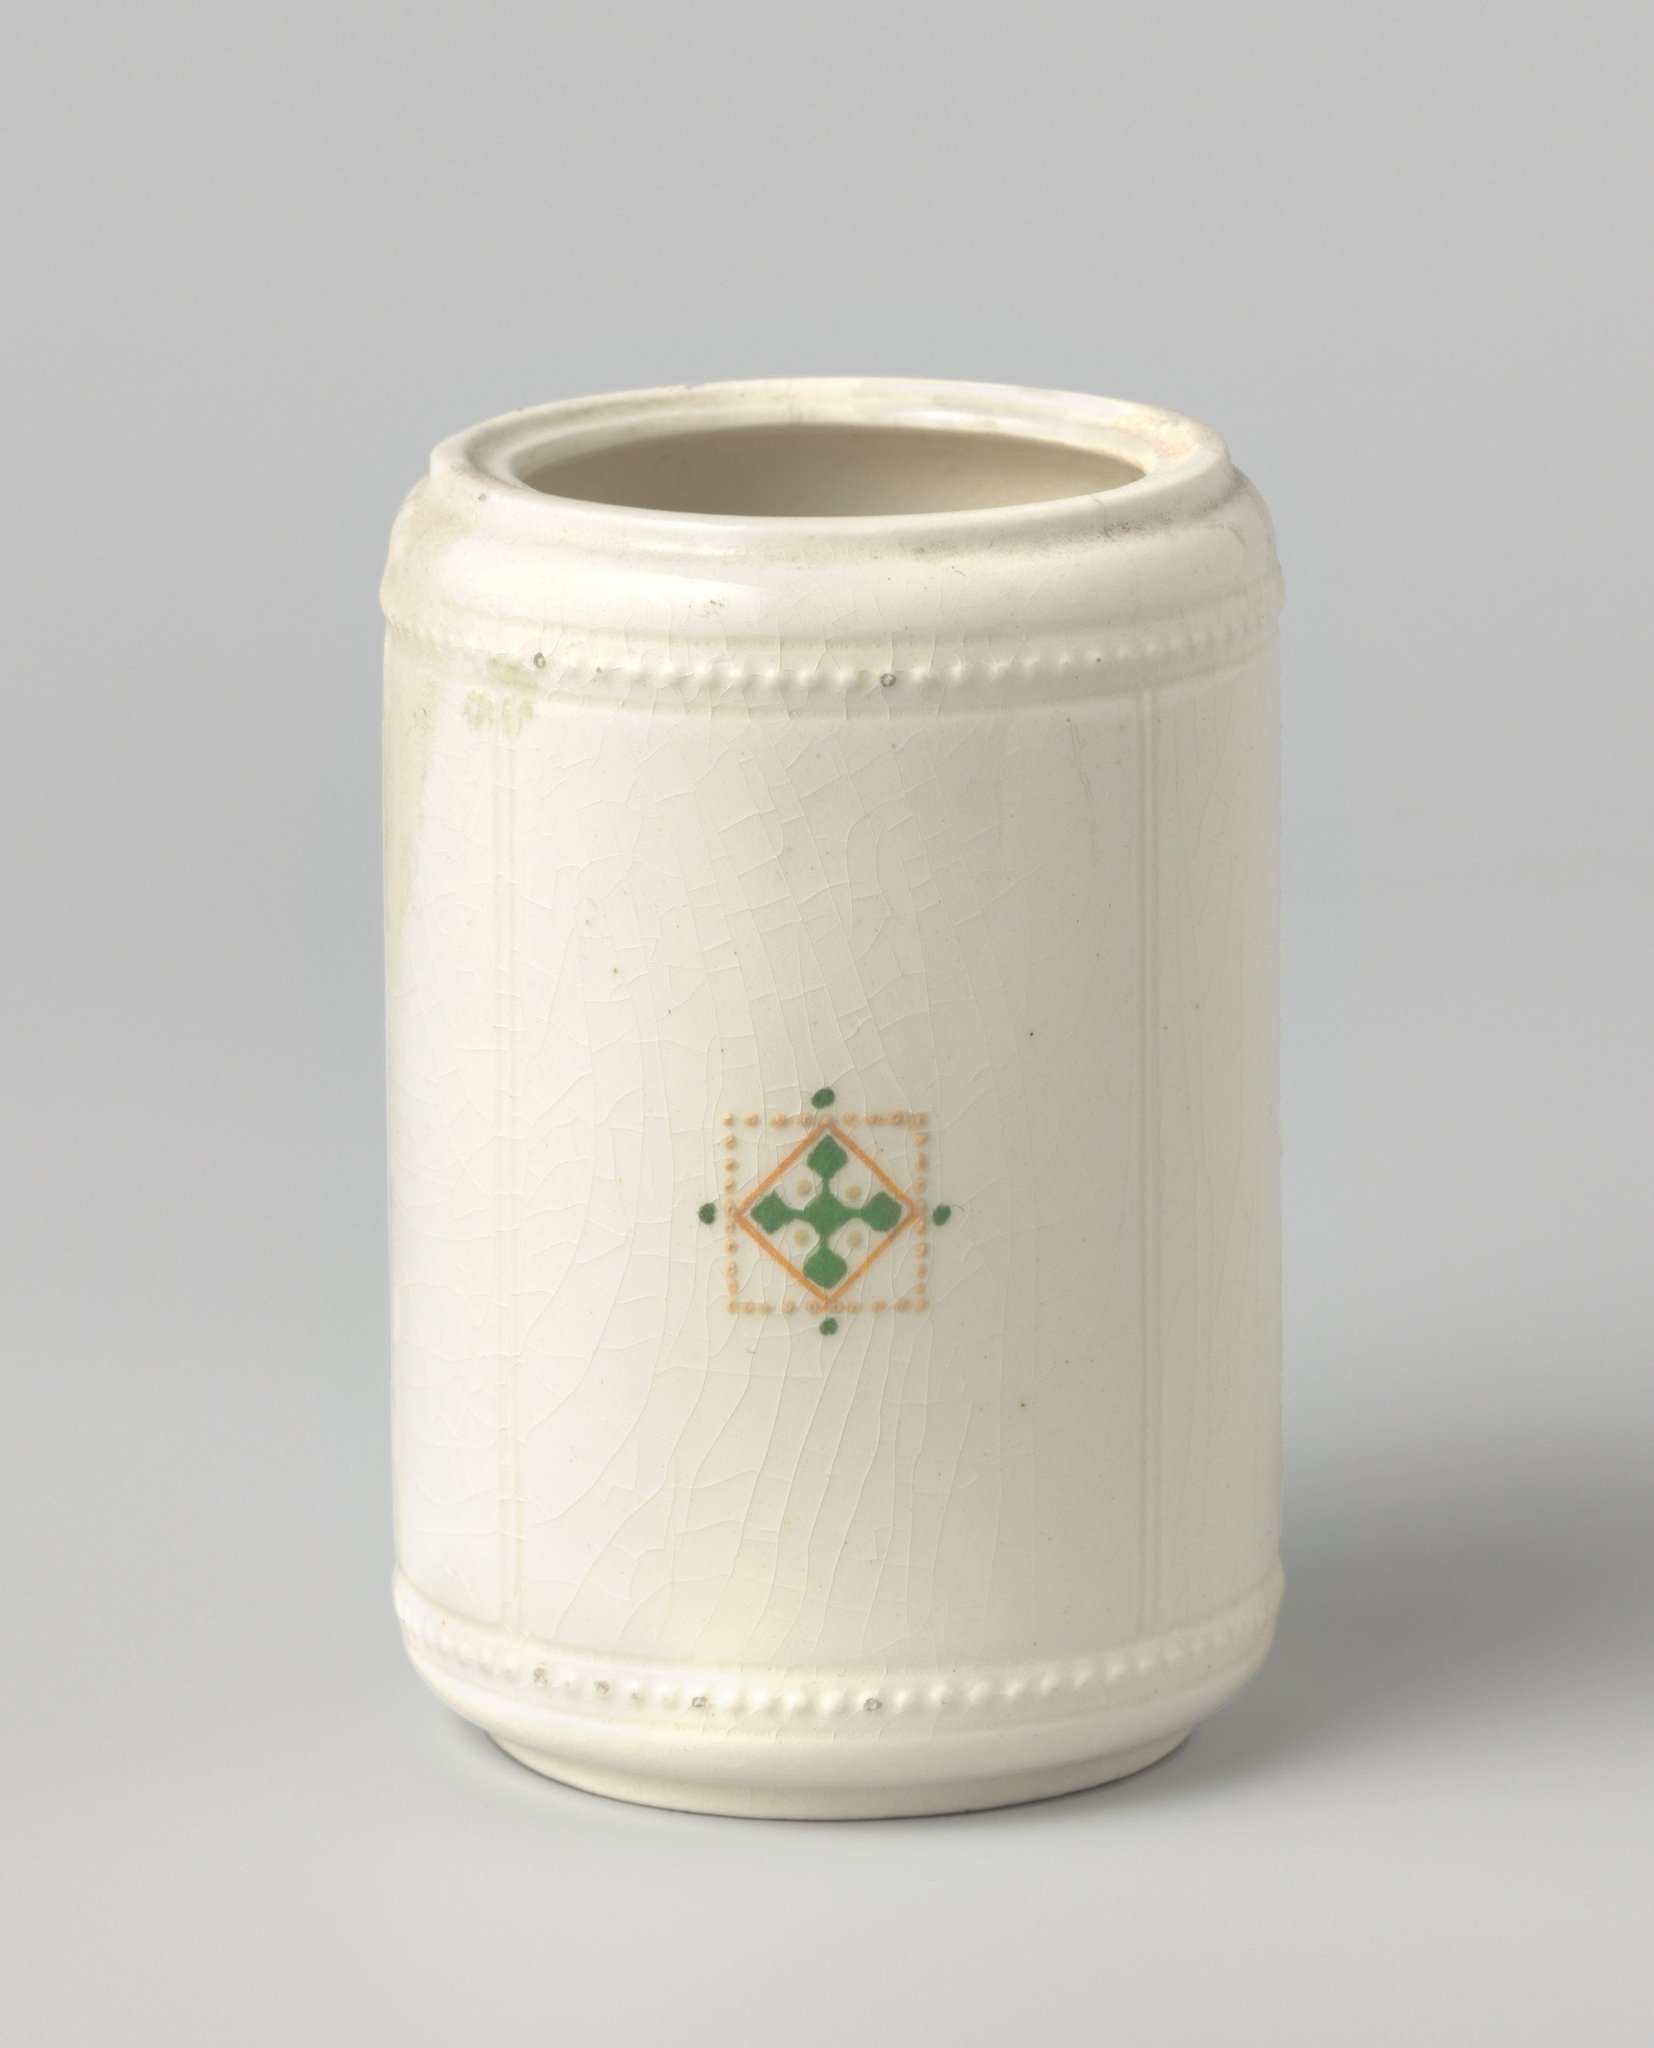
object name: pot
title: Pot met parellijst en geometrische motieven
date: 1904-1910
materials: earthenware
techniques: painted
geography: amsterdam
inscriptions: mark: ‘AMSTELHOEK (rond stempel, waarin monogram AH met tussen de poten van de letter H nogeens de letters V.H) ); AMSTERDAM HOLLAND (in blauw); AM (ingegrift)’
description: Pot van aardewerk, cylindervormig. Even boven de voetrand en onder de mondrand is de pot versierd met een parellijst. De wand is verticaal ingedeeld in velden door middel van ingekerfde dubbele lijnen. Twee van deze velden zijn versierd met een geometrisch motief bestaande uit een geel vierkant, waarbinnen een oranje ruit, waarbinnen een groen kruisvormig motief is geschilderd. Bij de pot hoort een deksel (B).